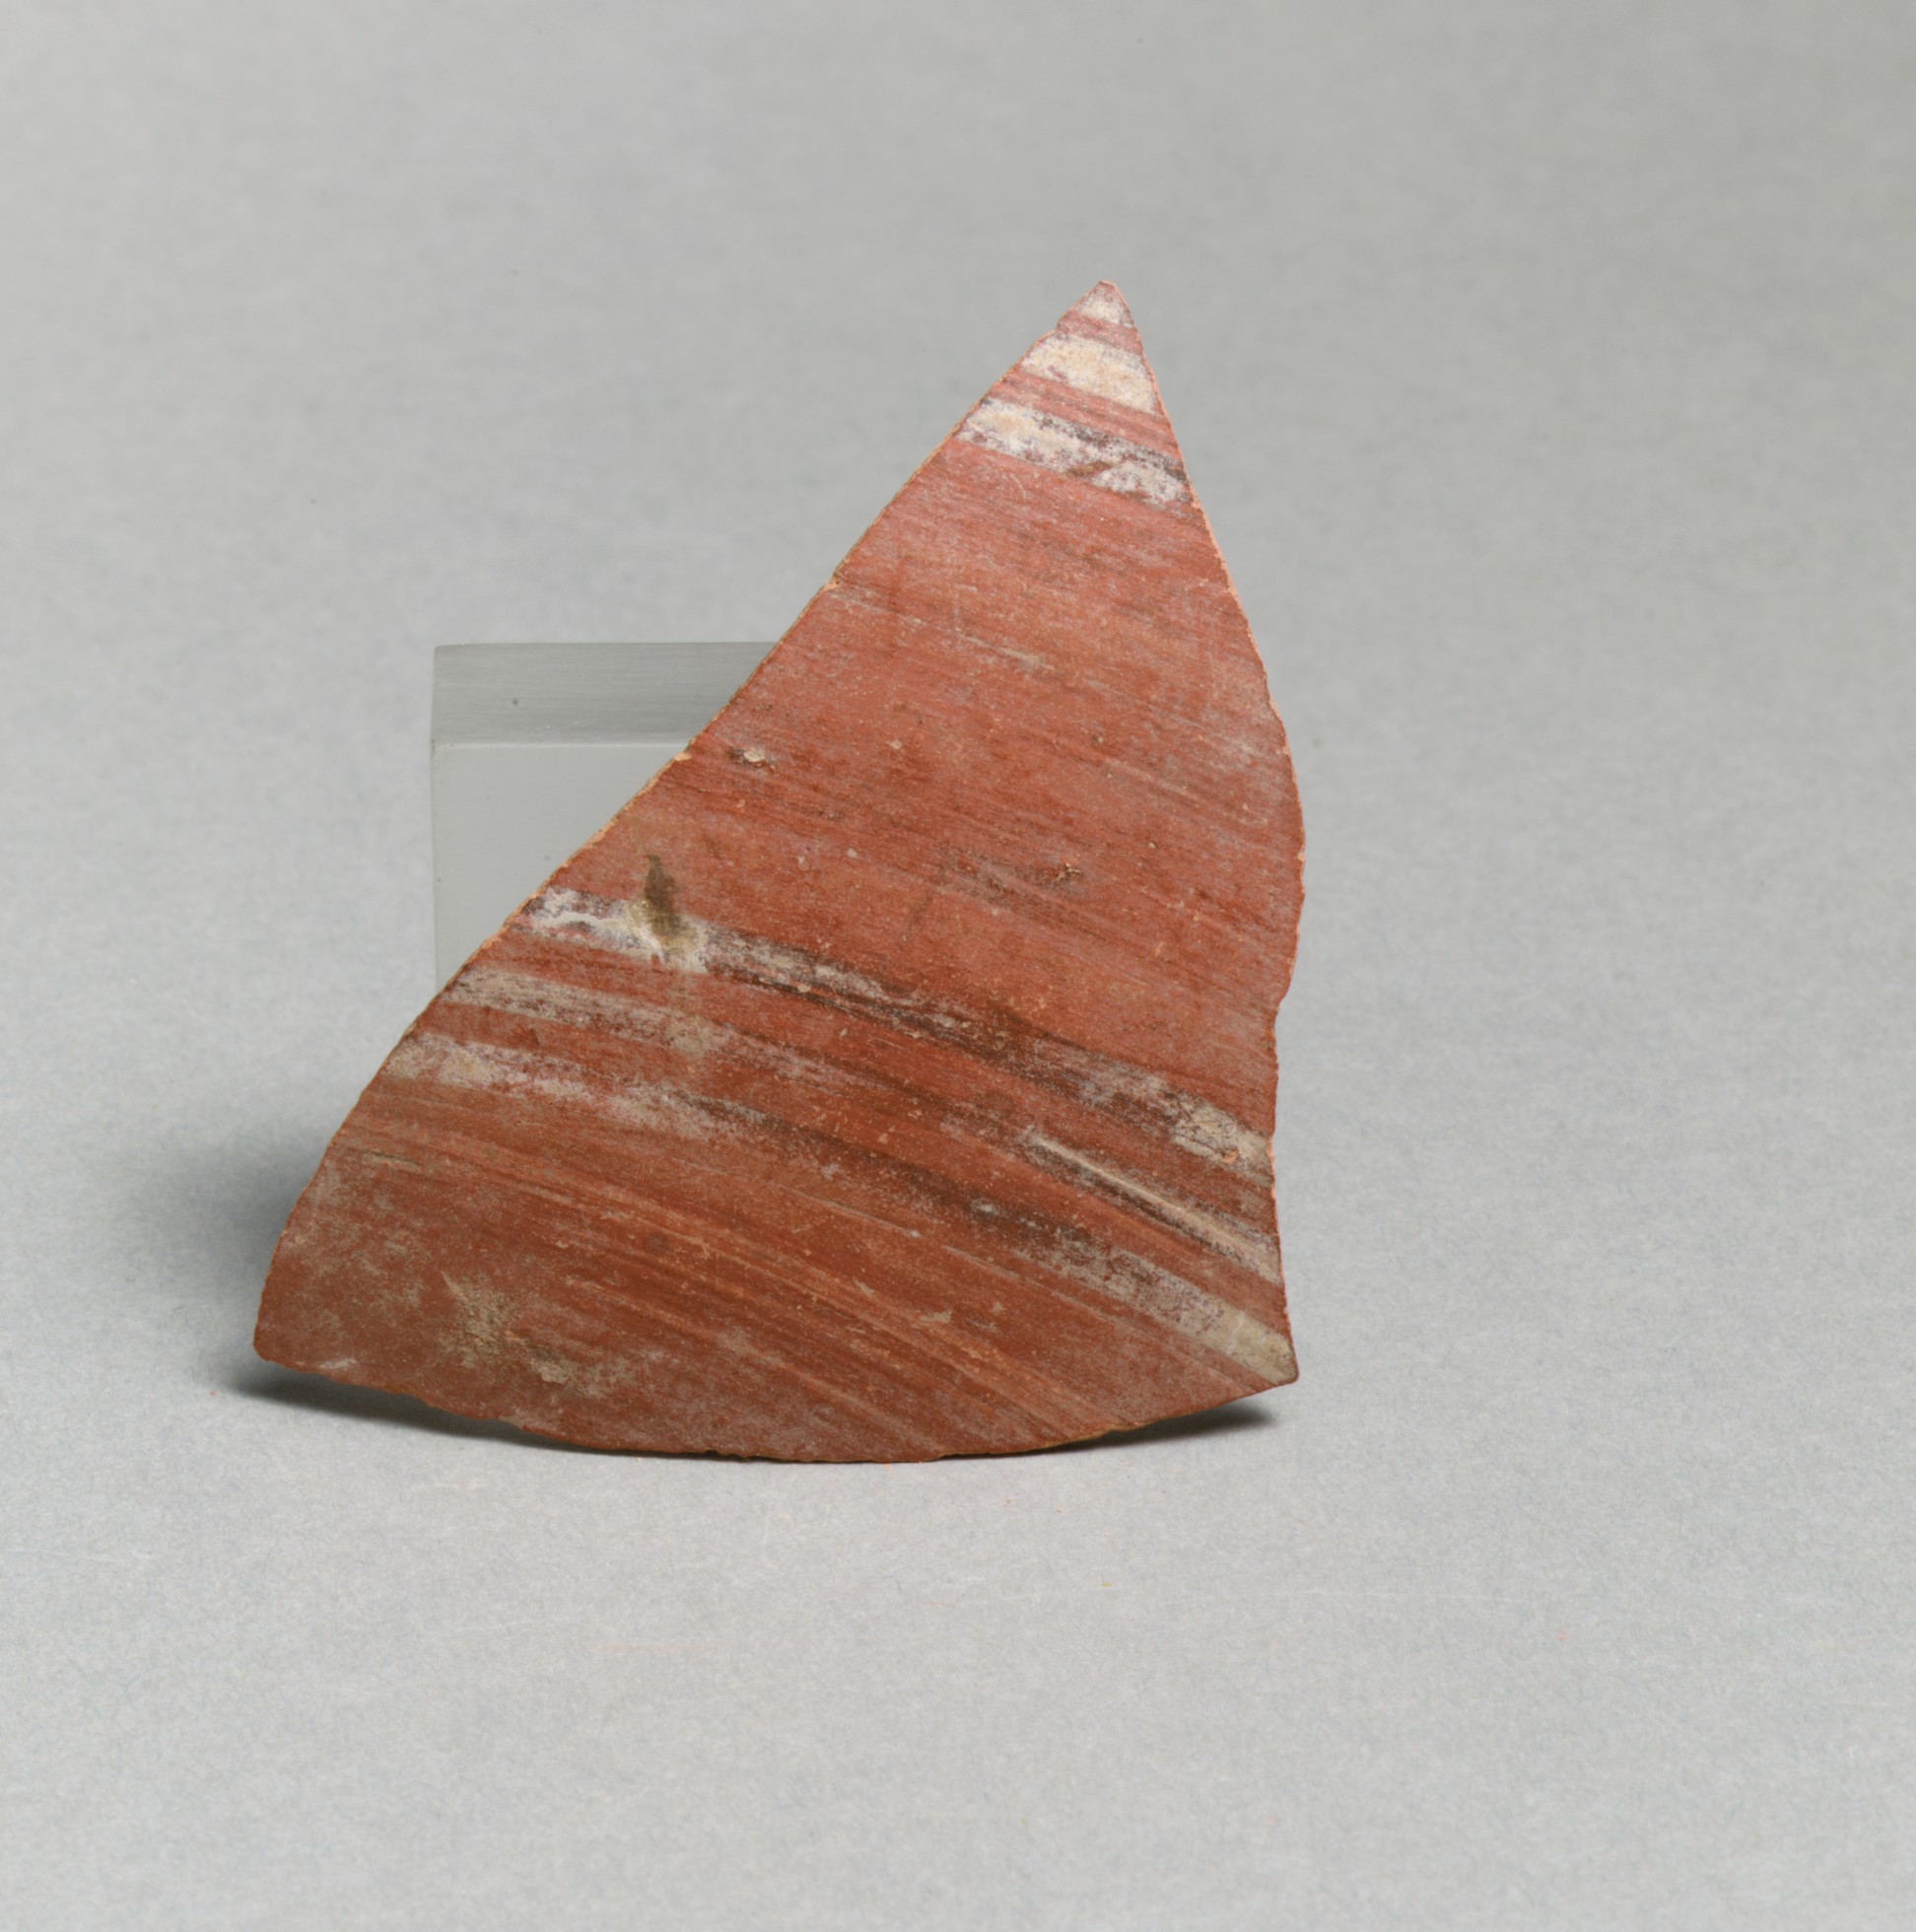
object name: vase fragment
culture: greek or lydian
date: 900-30 BCE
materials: terracotta